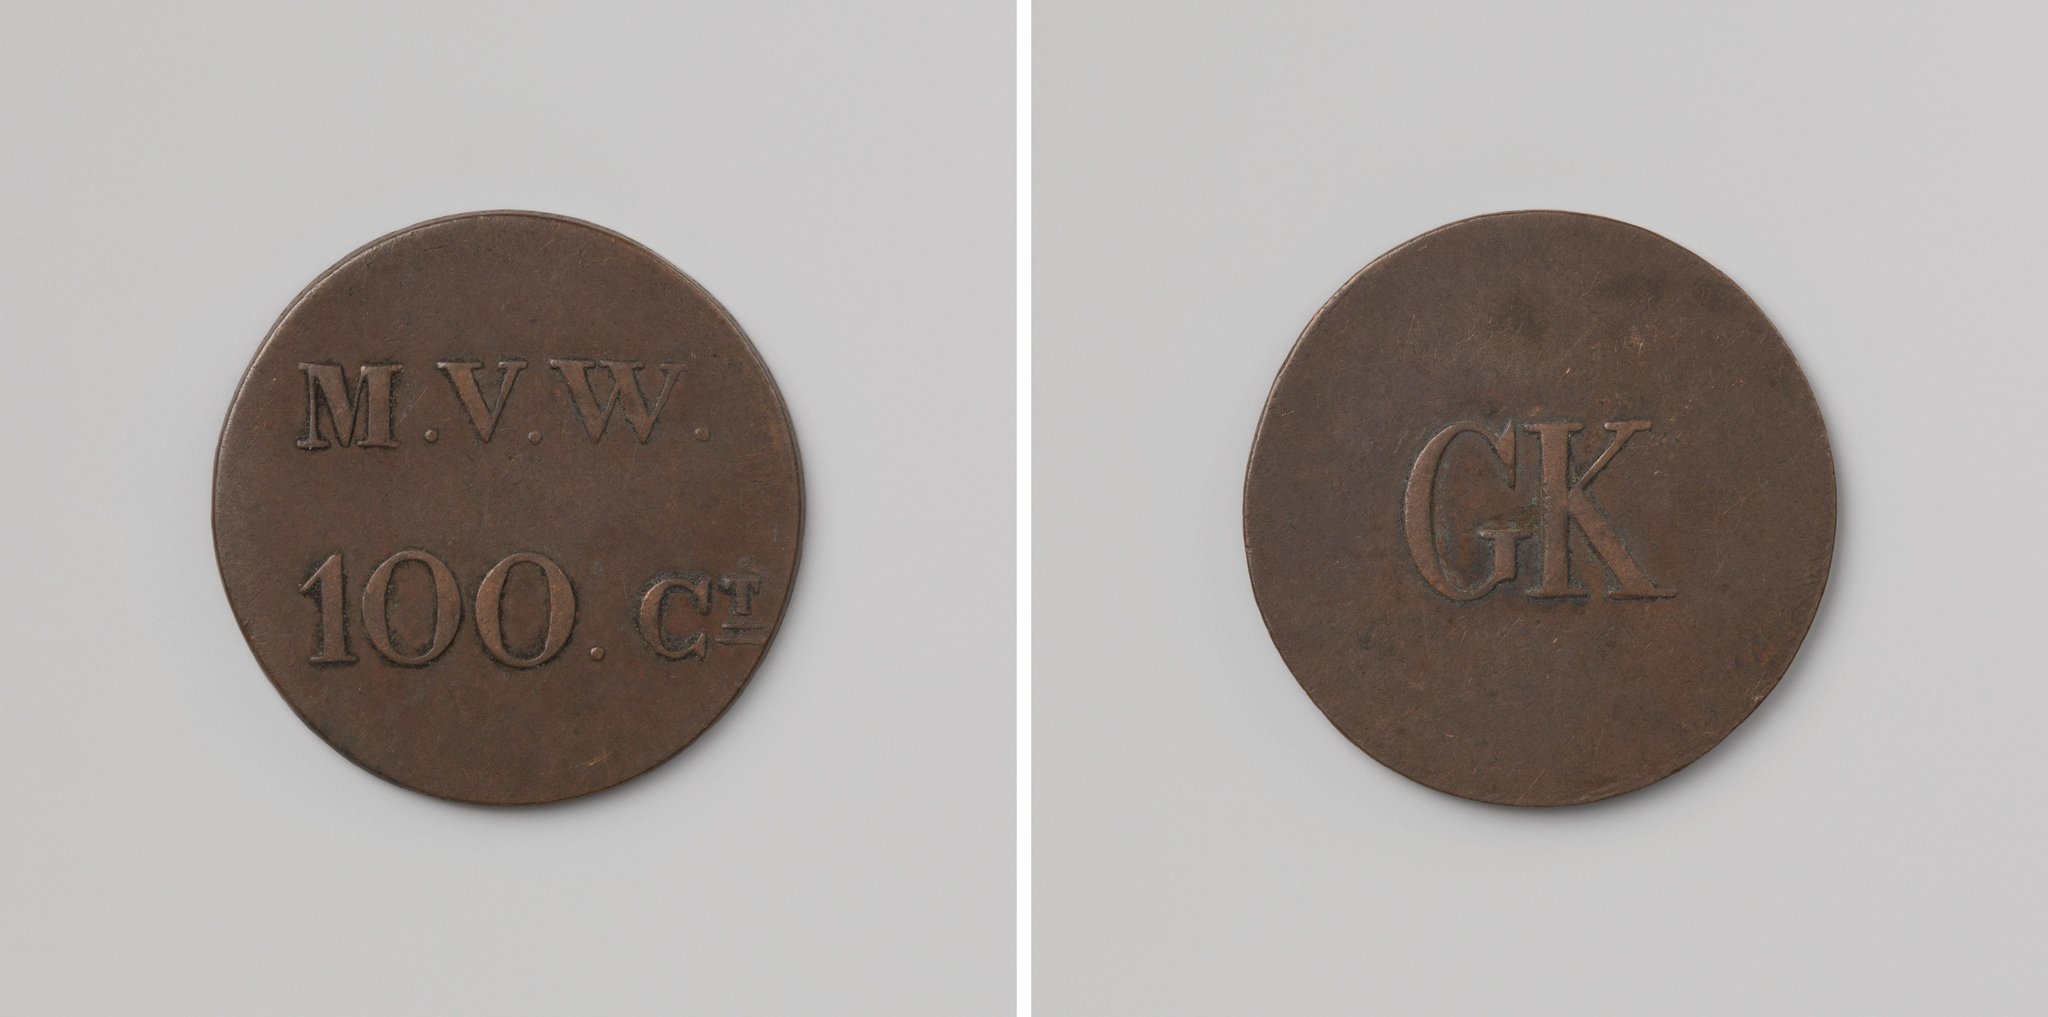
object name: honderd cent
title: Huismunt geslagen op last van de Maatschappij van Weldadigheid ter waarde van 1 gulden, ten behoeve van de Gewone Koloniën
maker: Anonymous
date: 1818-1859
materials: copper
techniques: striking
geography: netherlands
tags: maatschappij van weldadigheid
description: Voorzijde: opschrift boven waardeaanduiding. Keerzijde: letters G en K